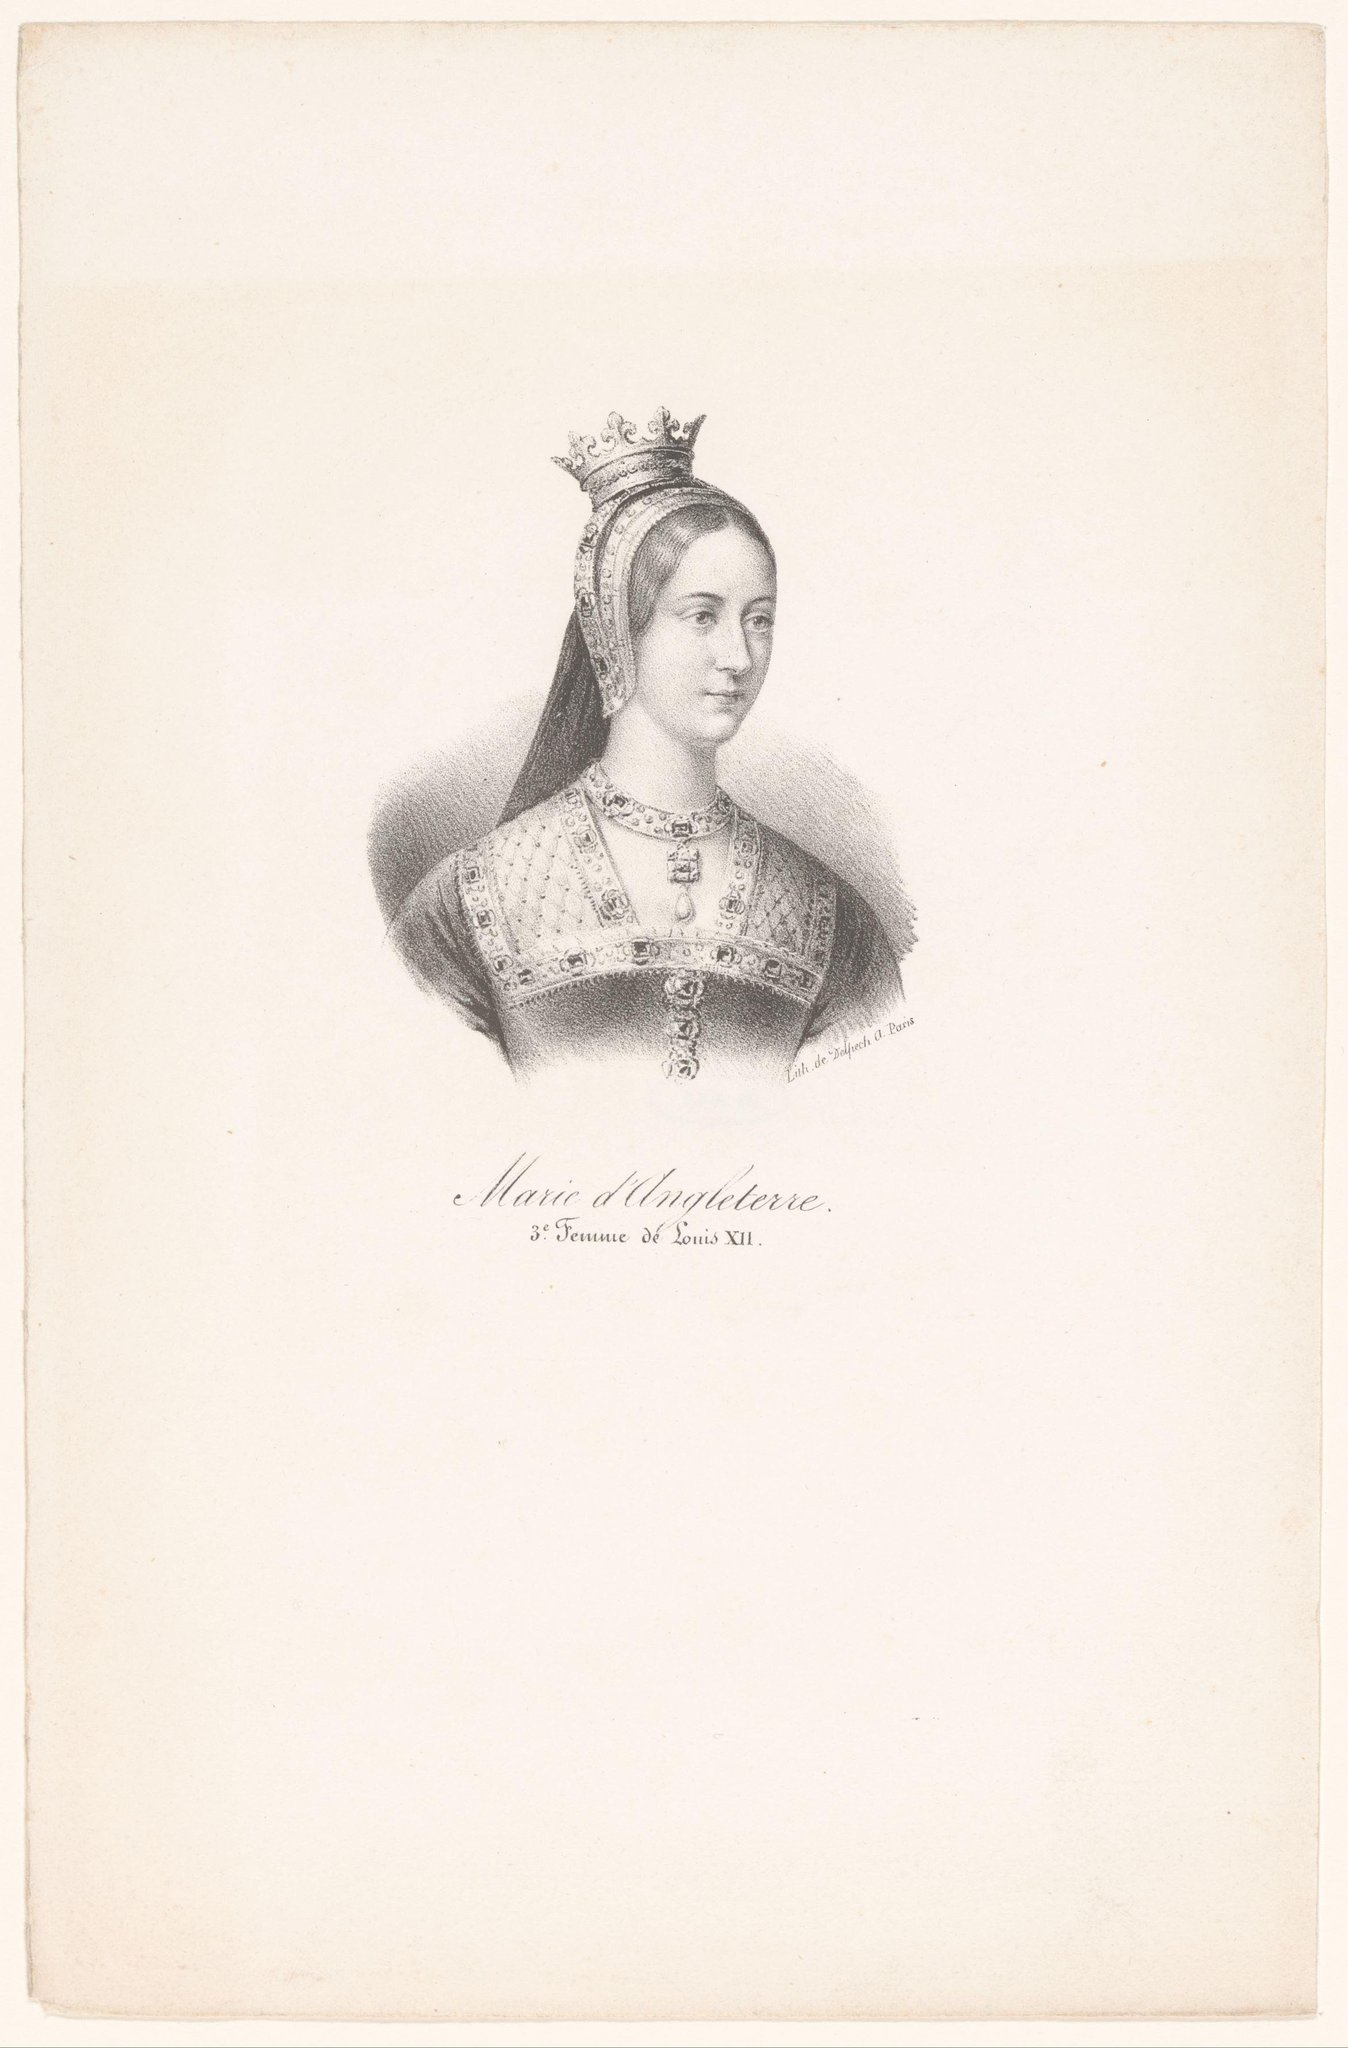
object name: print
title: Marie d'Angleterre, 3e femme de Louis XII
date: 1818-1842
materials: paper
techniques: lithograph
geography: paris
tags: historical persons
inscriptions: collector's mark: Lugt 2228a